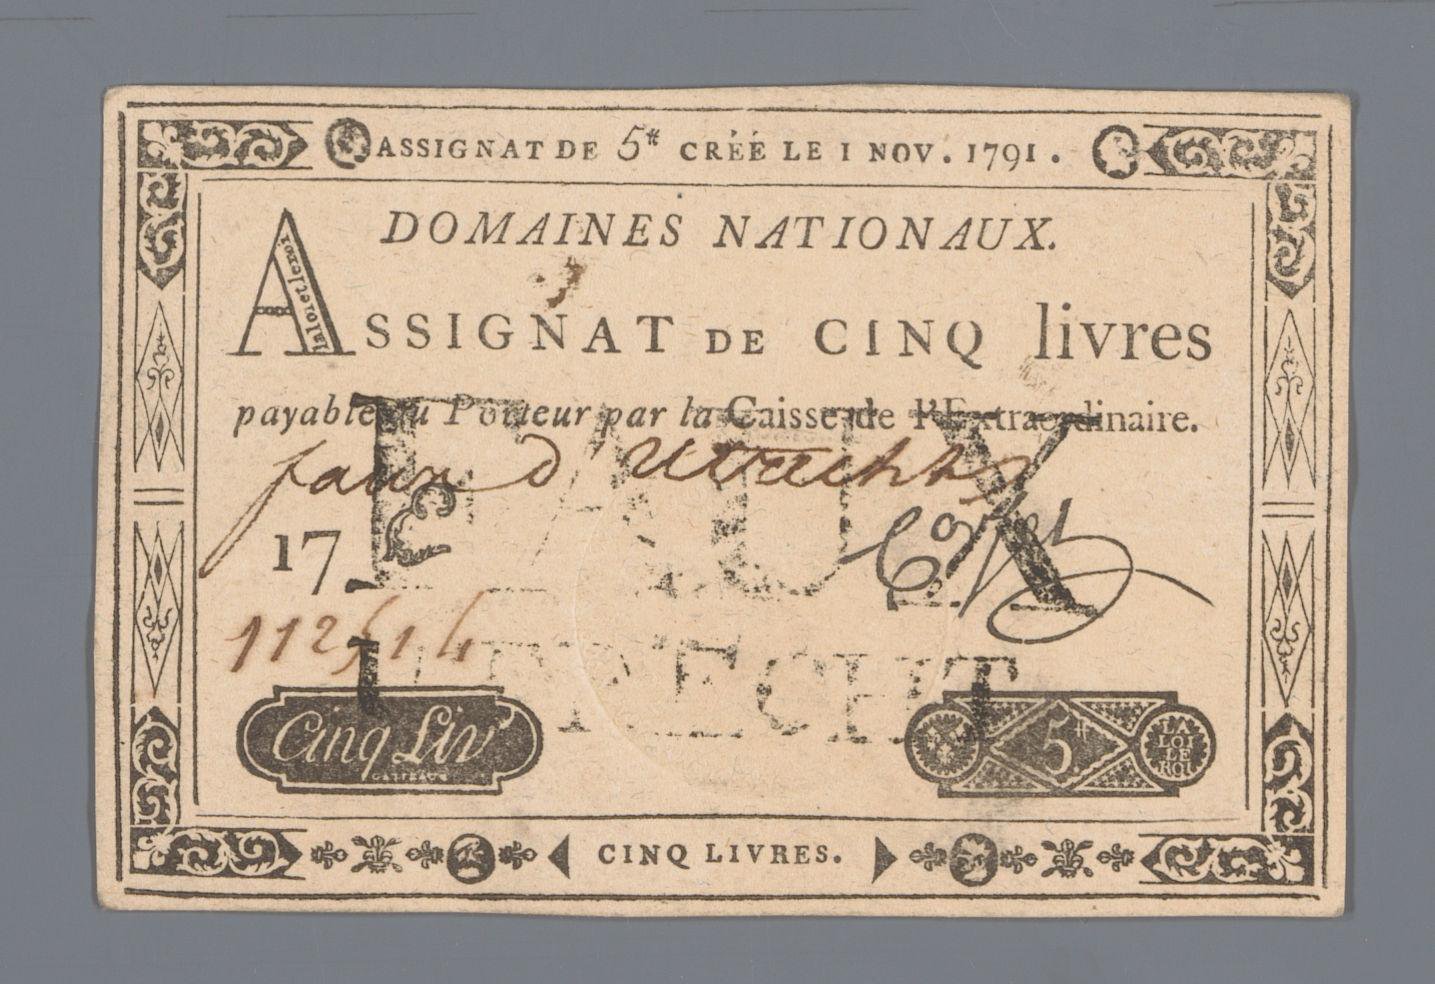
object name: assignat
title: Te Utrecht ongeldig gemaakte assignat van vijf livres, serie 17 E, nr. 112514 uitgegeven 1 november 1791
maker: nicolas marie gatteaux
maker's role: medailleur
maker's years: 1751-1832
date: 1791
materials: ink, paper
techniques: printing, writing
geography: paris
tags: lodewijk xvi (koning van frankrijk), utrecht, france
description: Eenzijdig bedrukte papiertje, assignaat van £5, met stempel 'Faux Utrecht'. Nr. 17. Aan de achterkant naam in pen.